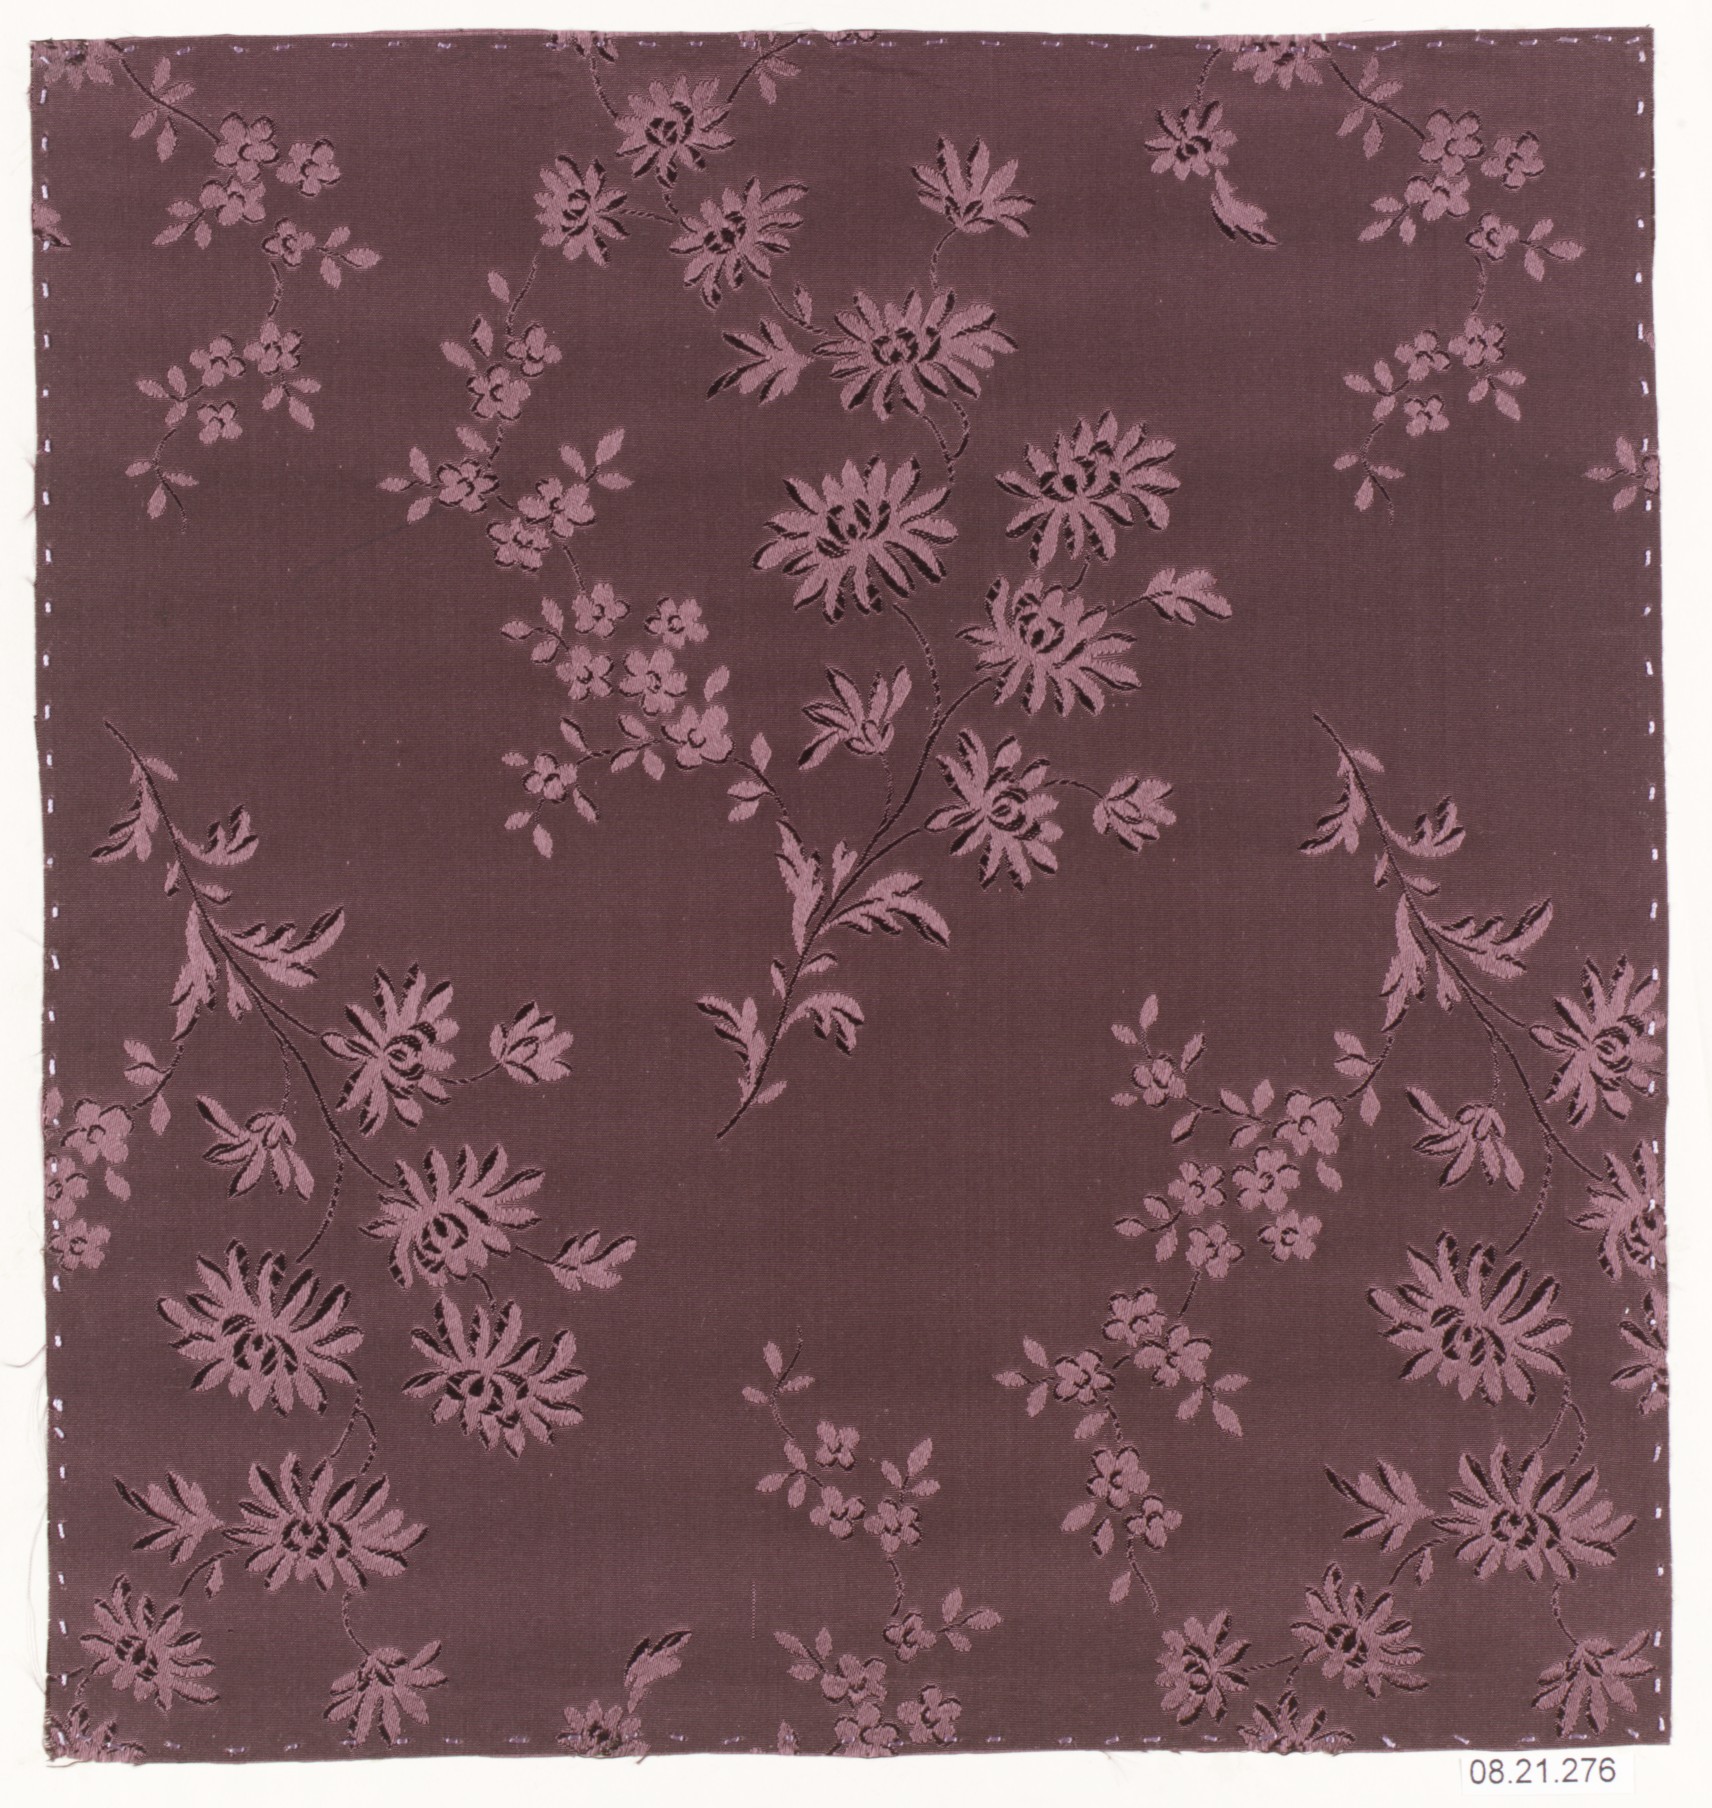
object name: textile sample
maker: Anonymous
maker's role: designer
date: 1900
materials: silk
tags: flowers